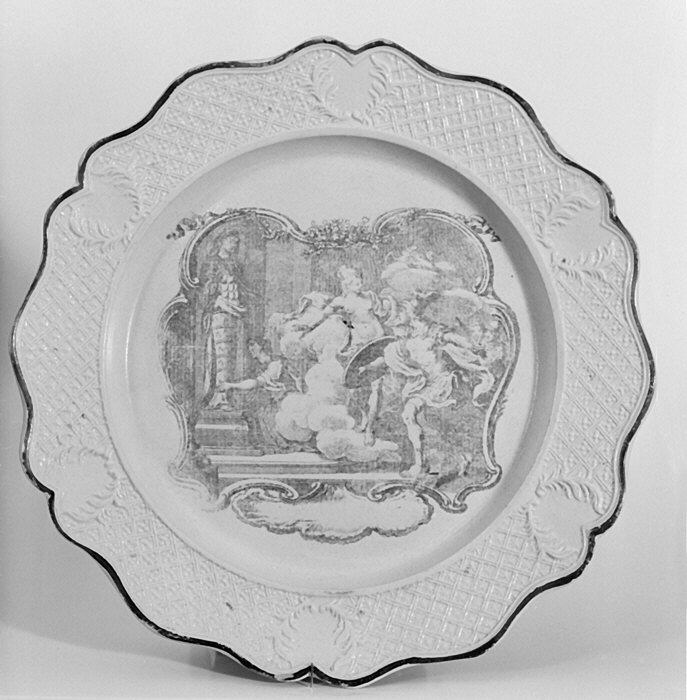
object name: plate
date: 1760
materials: stoneware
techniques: salt glaze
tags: human figures